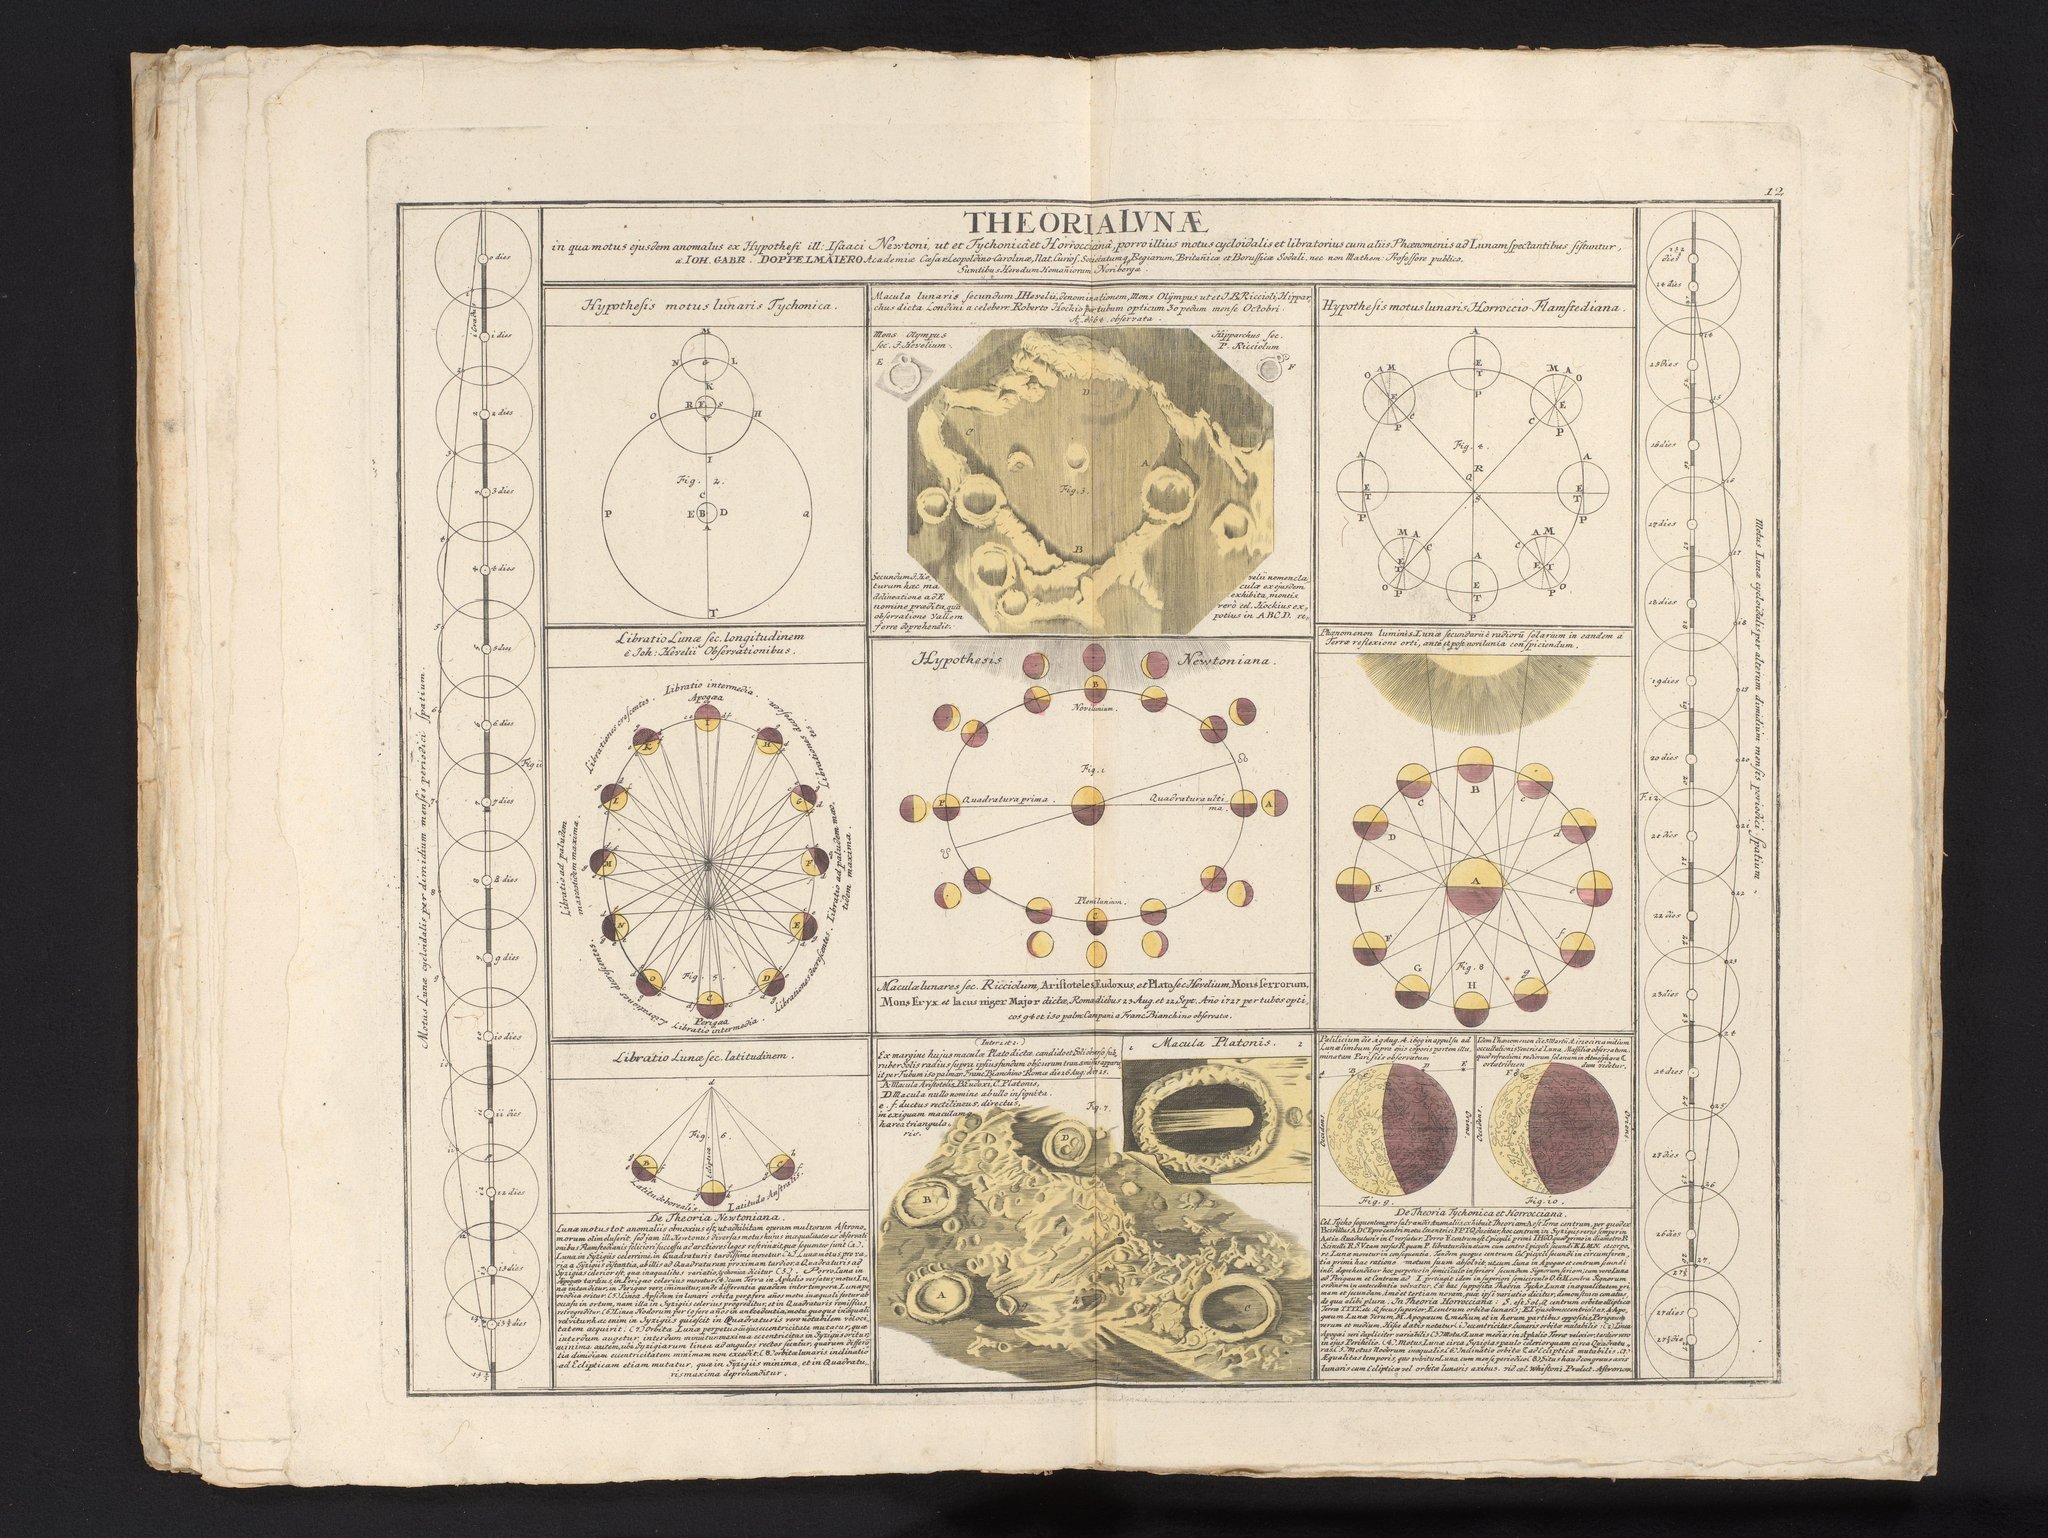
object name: print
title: Diagrammen met theorieën en uitleg over de maan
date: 1742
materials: paper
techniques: engraving, etching, hand coloring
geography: nuremberg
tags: meteor, moon as celestial body